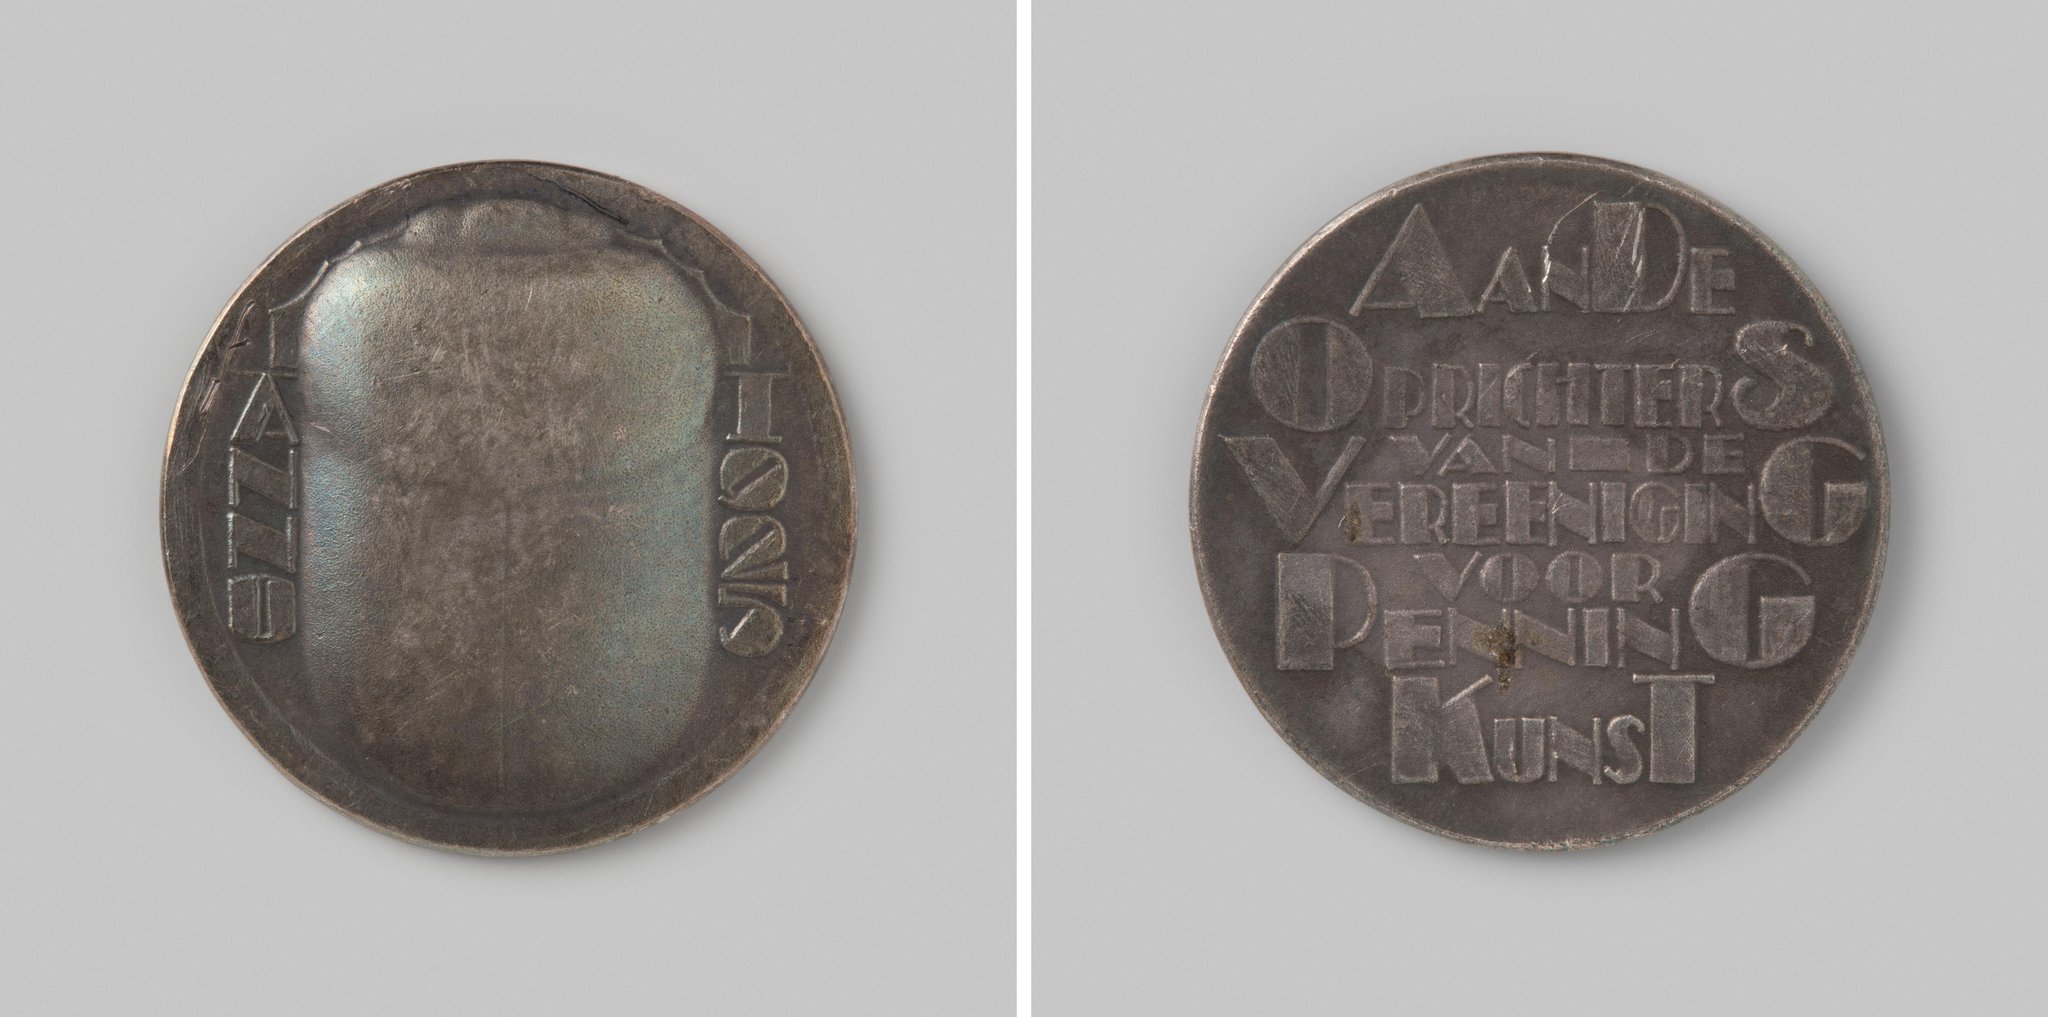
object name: medal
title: Stichtingspenning van de Vereniging voor Penningkunst (1925)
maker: chris van der hoef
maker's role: ceramicist, draughtsman, sculptor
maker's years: 1875-1933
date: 1925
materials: silver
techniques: striking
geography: voorschoten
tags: insects: scarabaeus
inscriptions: inscription: ‘Anno 1925 / Aan de oprichters van de Vereniging voor Penningkunst’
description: De kever scarabaeus sacer gold in Egypte wegens zijn levenswijze als het zinnebeeld van de jeugdige zonnegod en belichaamde het leven dat uit de diepte van de onderwereld steeds weer opnieuw ontstond. Men geloofde dat de jonge kever zo uit de kluitjes mest, die de oude kever met zijn pootjes voortrolt, te voorschijn komt en dus uit aarde ontstaat. Men zag hierin een analogie met de loop van de zon en haar wedergeboorte elke morgen. De scarabee werd de meest geliefde zegelamulet en er zijn talloze exemplaren van overgeleverd in verschillende materialen. Carel Begeer, een van de stichters van de VPK liet de stichtingspenning in een heel kleine oplage vervaardigen voor de mede-oprichters van de Vereniging. In handen van Van der Hoef is het een uitgesproken Art Deco-ontwerp geworden, het thema is bedoeld om de regeneratie van de Nederlandse penningkunst te verbeelden. De dikke kever drukt de letters en cijfers 'Anno 1925' ongeveer over de rand en aan de keerzijde ziet men eenzelfde expansie van binnen naar buiten: de letters die aan de cirkelrand raken zijn tweemaal zo groot als die in het centrum; de schaalverschillen zijn gedicteerd door de cirkelvorm en hun contrast van dun en dik geven een mooi, bijna abstract beeld.